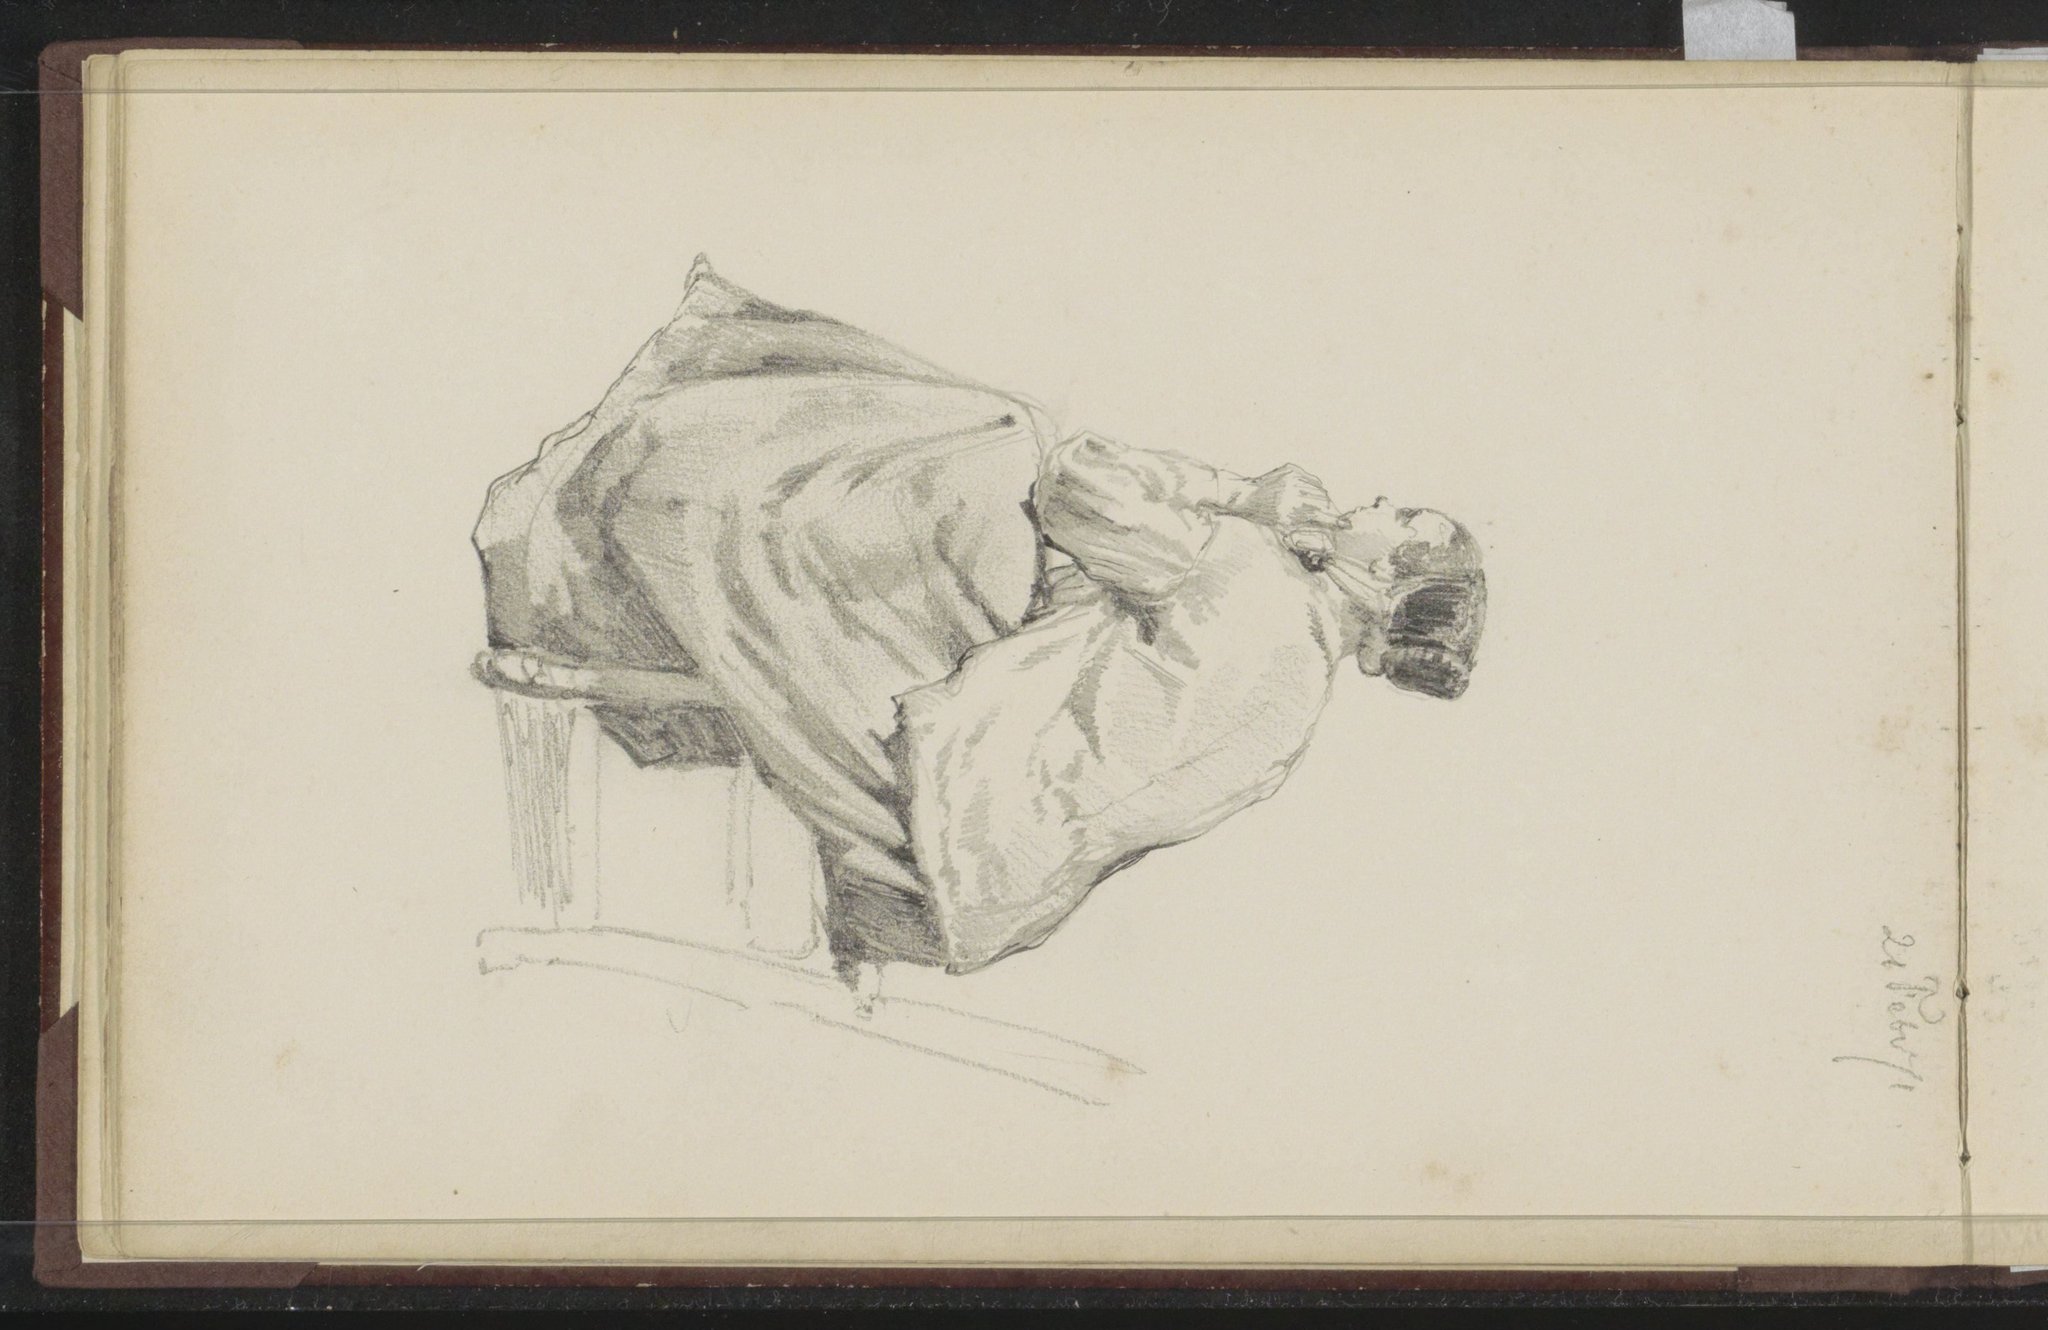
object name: sketchbook leaf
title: Vrouw op een stoel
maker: cornelis springer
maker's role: draughtsman, painter, print maker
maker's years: 1817-1891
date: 1871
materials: paper, pencil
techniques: stumping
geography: netherlands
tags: sitting on an elevation - aa - female human figure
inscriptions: date: ‘21 Febr 71’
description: Vrouw op een stoel. Blad 7 verso uit een schetsboek met 39 bladen, deels vervaardigd te Ulm en Leiden.